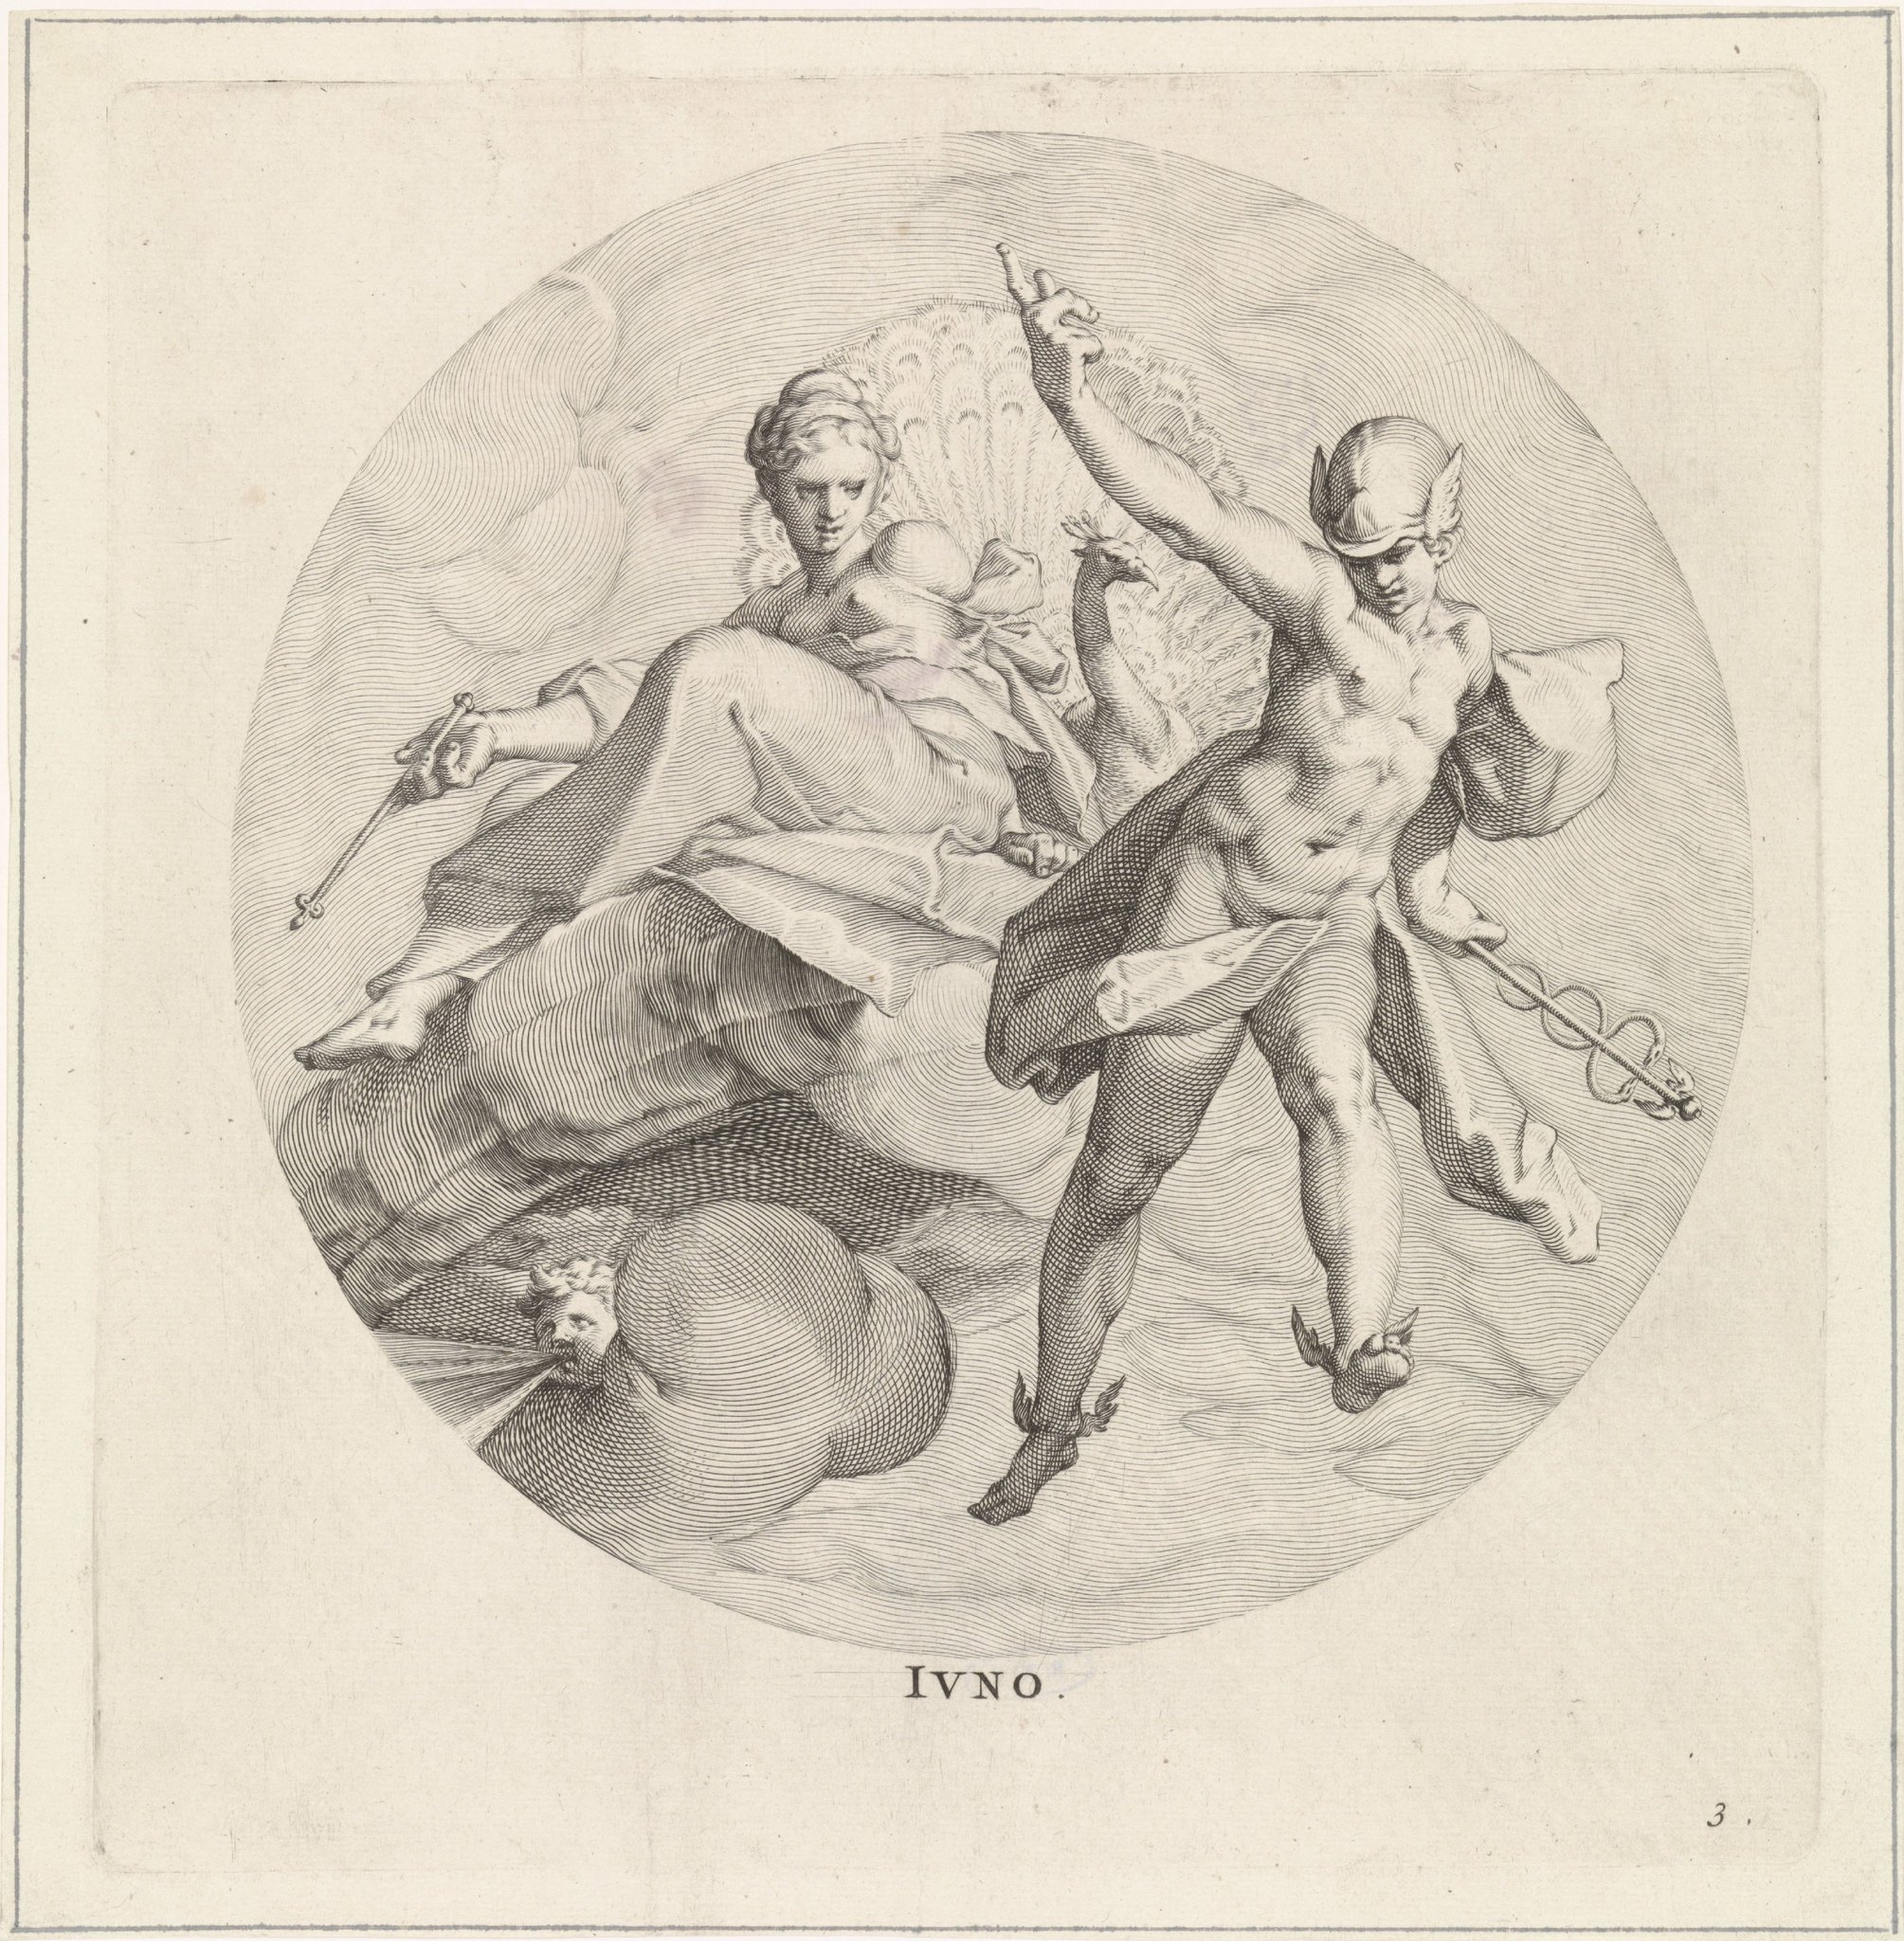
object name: print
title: Godinnen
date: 1590-1637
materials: paper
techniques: engraving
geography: antwerp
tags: (story of) juno (hera), (story of) mercury (hermes)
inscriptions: collector's mark: Lugt 2228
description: Juno met een scepter in de hand, zittend op een wolk. Achter haar zit haar attribuut de pauw. Ze kijkt naar Mercurius. De voorstelling is gevat in een ronde omlijsting. Derde prent uit een serie van drie met godinnen.